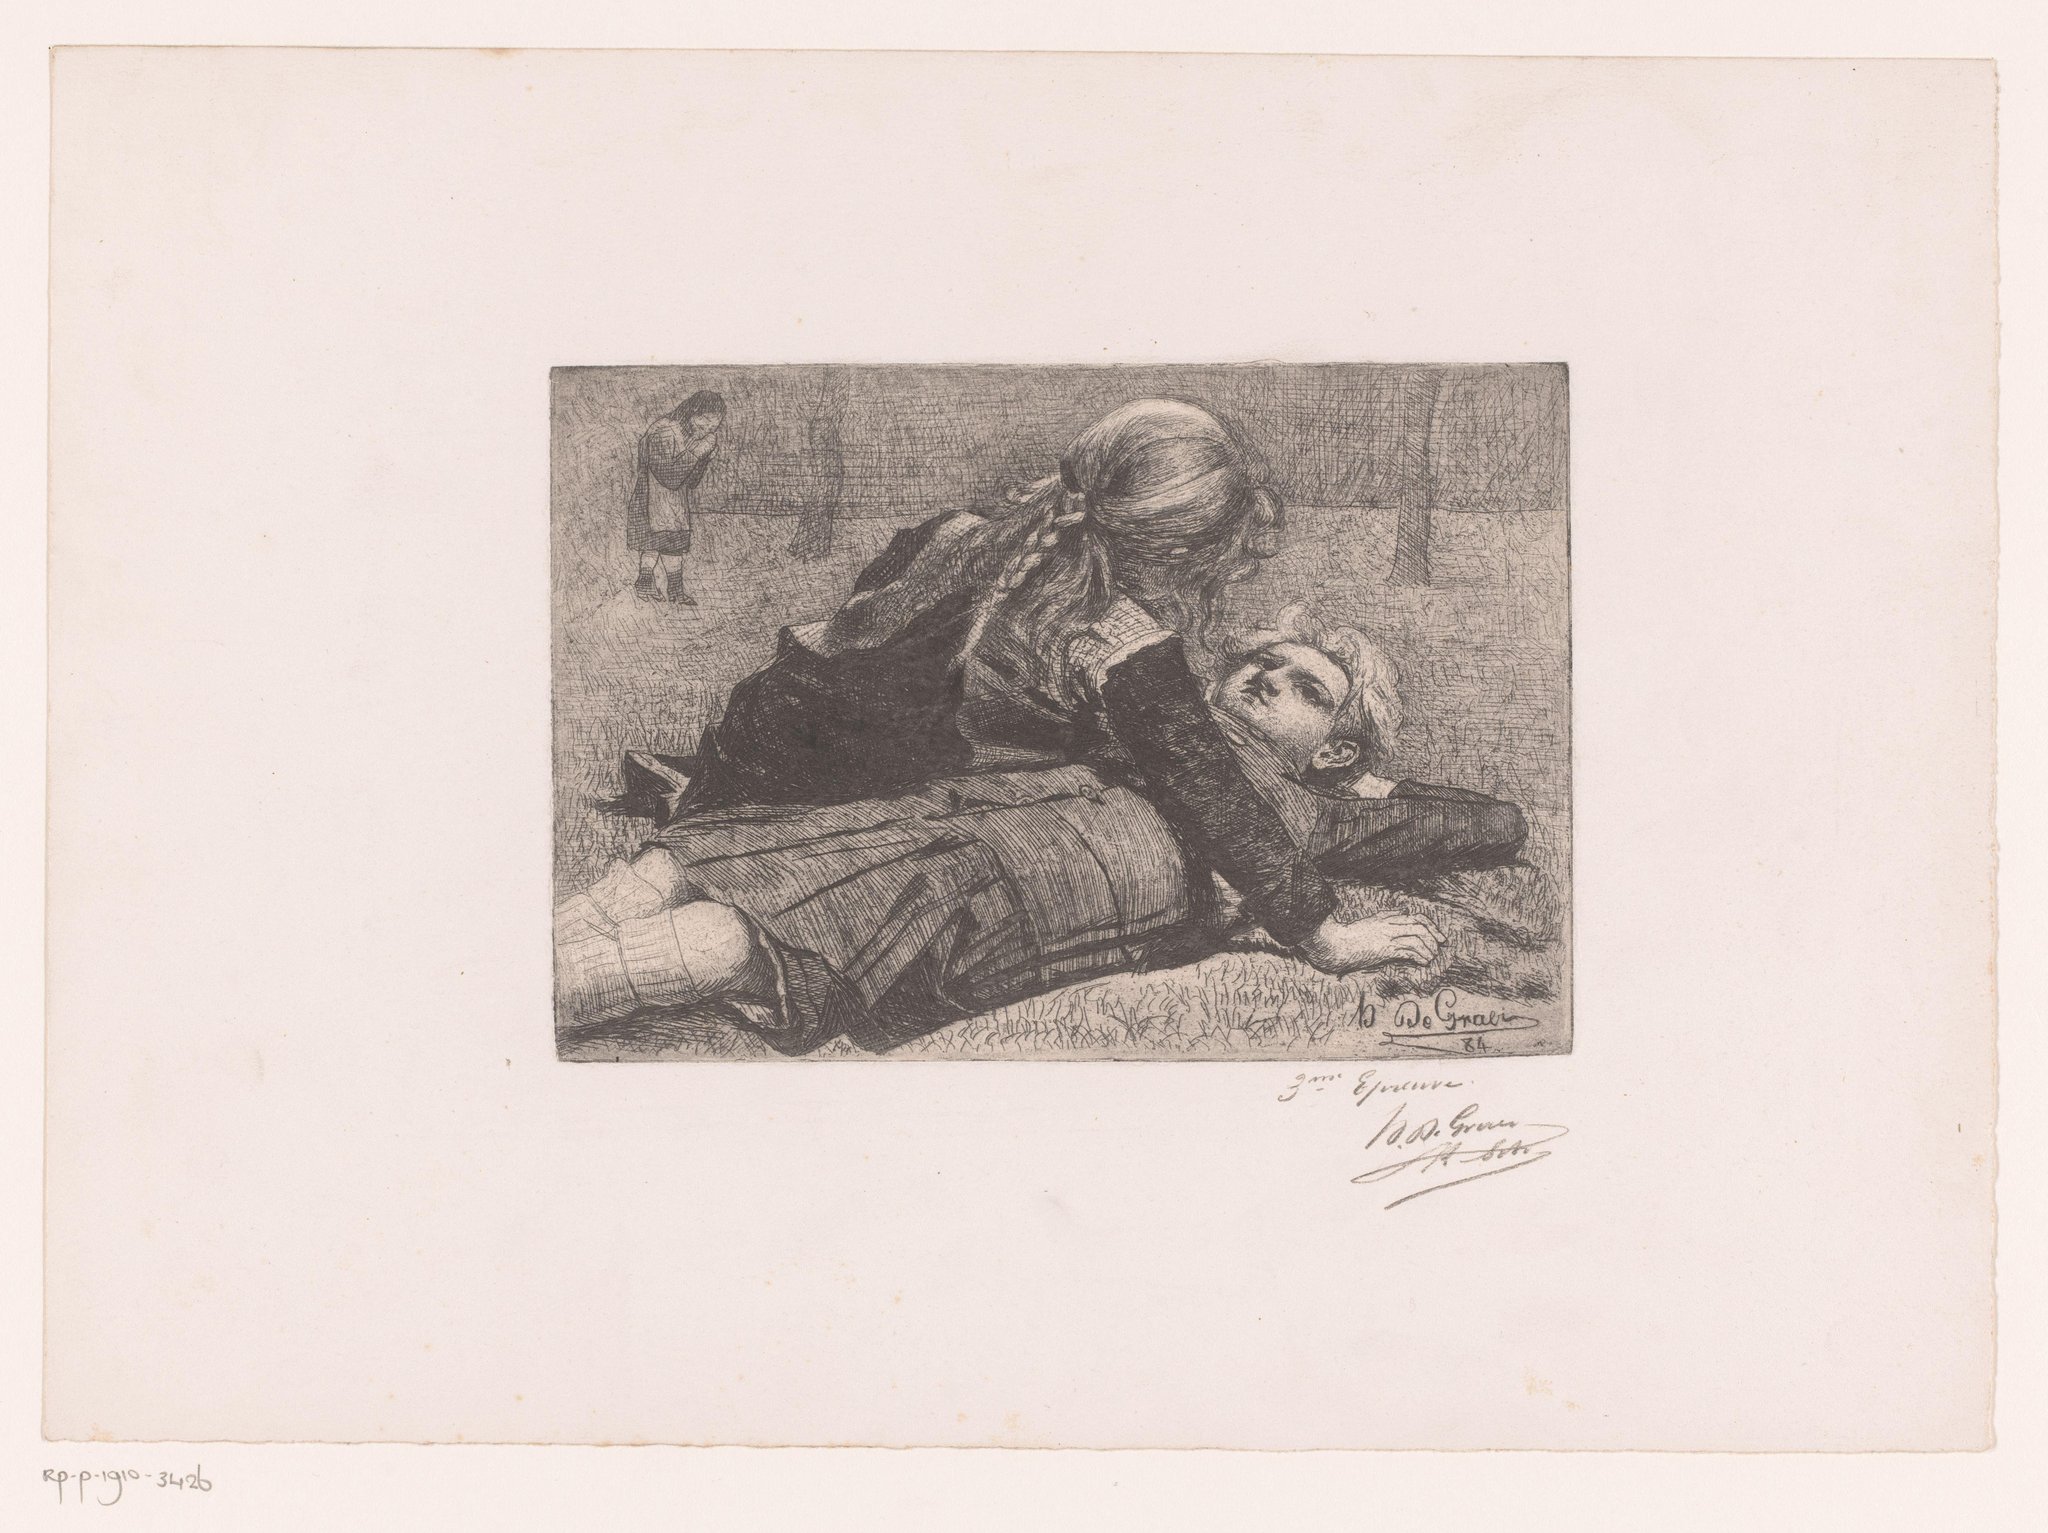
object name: print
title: Twee kinderen liggen in het gras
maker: henri de graer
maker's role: painter, print maker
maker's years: 1856-1915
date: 1884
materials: paper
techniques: etching, intaglio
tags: lying on the back with hands under the head, leaning sideways - aa - female human figure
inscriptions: collector's mark: Lugt 2228, annotation: ‘3me Epreuve’